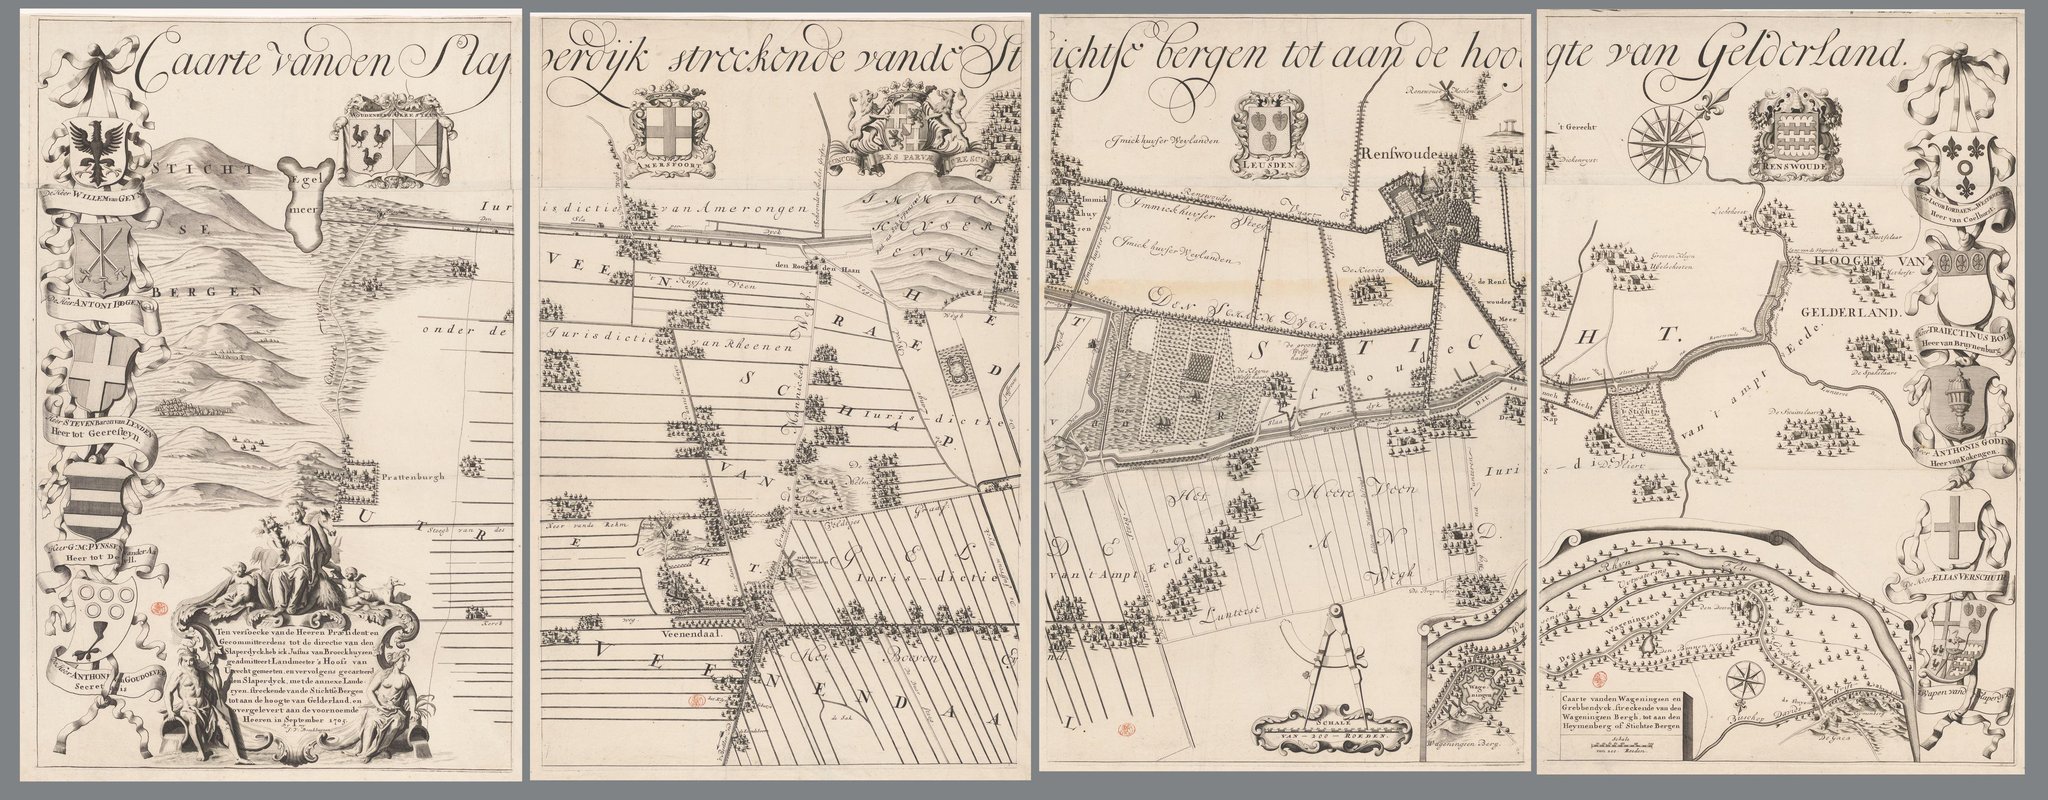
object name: print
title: Caarte vanden Slaperdijk streckende vande Stichtse bergen tot aan de hoogte van Gelderland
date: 1705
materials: paper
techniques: engraving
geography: utrecht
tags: coat of arms (as symbol of the state, etc.), 'cornucopia', horn of plenty, maps of separate countries or regions, hunting, chase, cattle, river-gods, dikes, levee, fishing (sports), gelderland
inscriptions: collector's mark: Lugt 2228, collector's mark: Lugt 195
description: Langs de bovenkant onder de titel de wapens van Woudenberg en van kasteel Geerestein, het wapen van Amersfoort, het wapen van de provincie Utrecht, het wapen van Leusden en het wapen van Renswoude. Langs de linkerkant de wapens van vijf leden van het College ter Directie van den Slaperdijk. Linksonder een cartouche met de opdracht. Daaromheen een riviergod, een putto met een visnet, een vrouwfiguur met de hoorn des overvloeds in haar hand en een paard en koe achter zich, een putto met een jachthond en een vrouwfiguur met vissen in haar hand. Rechtsonder een schaalstok: Schale van 200 roeden. Daarnaast een inzetkaart van de Wageningse Grebbedijk. Langs de rechterkant de wapens van vier leden van het College ter Directie van den Slaperdijk en het wapen van de Slaperdijk.